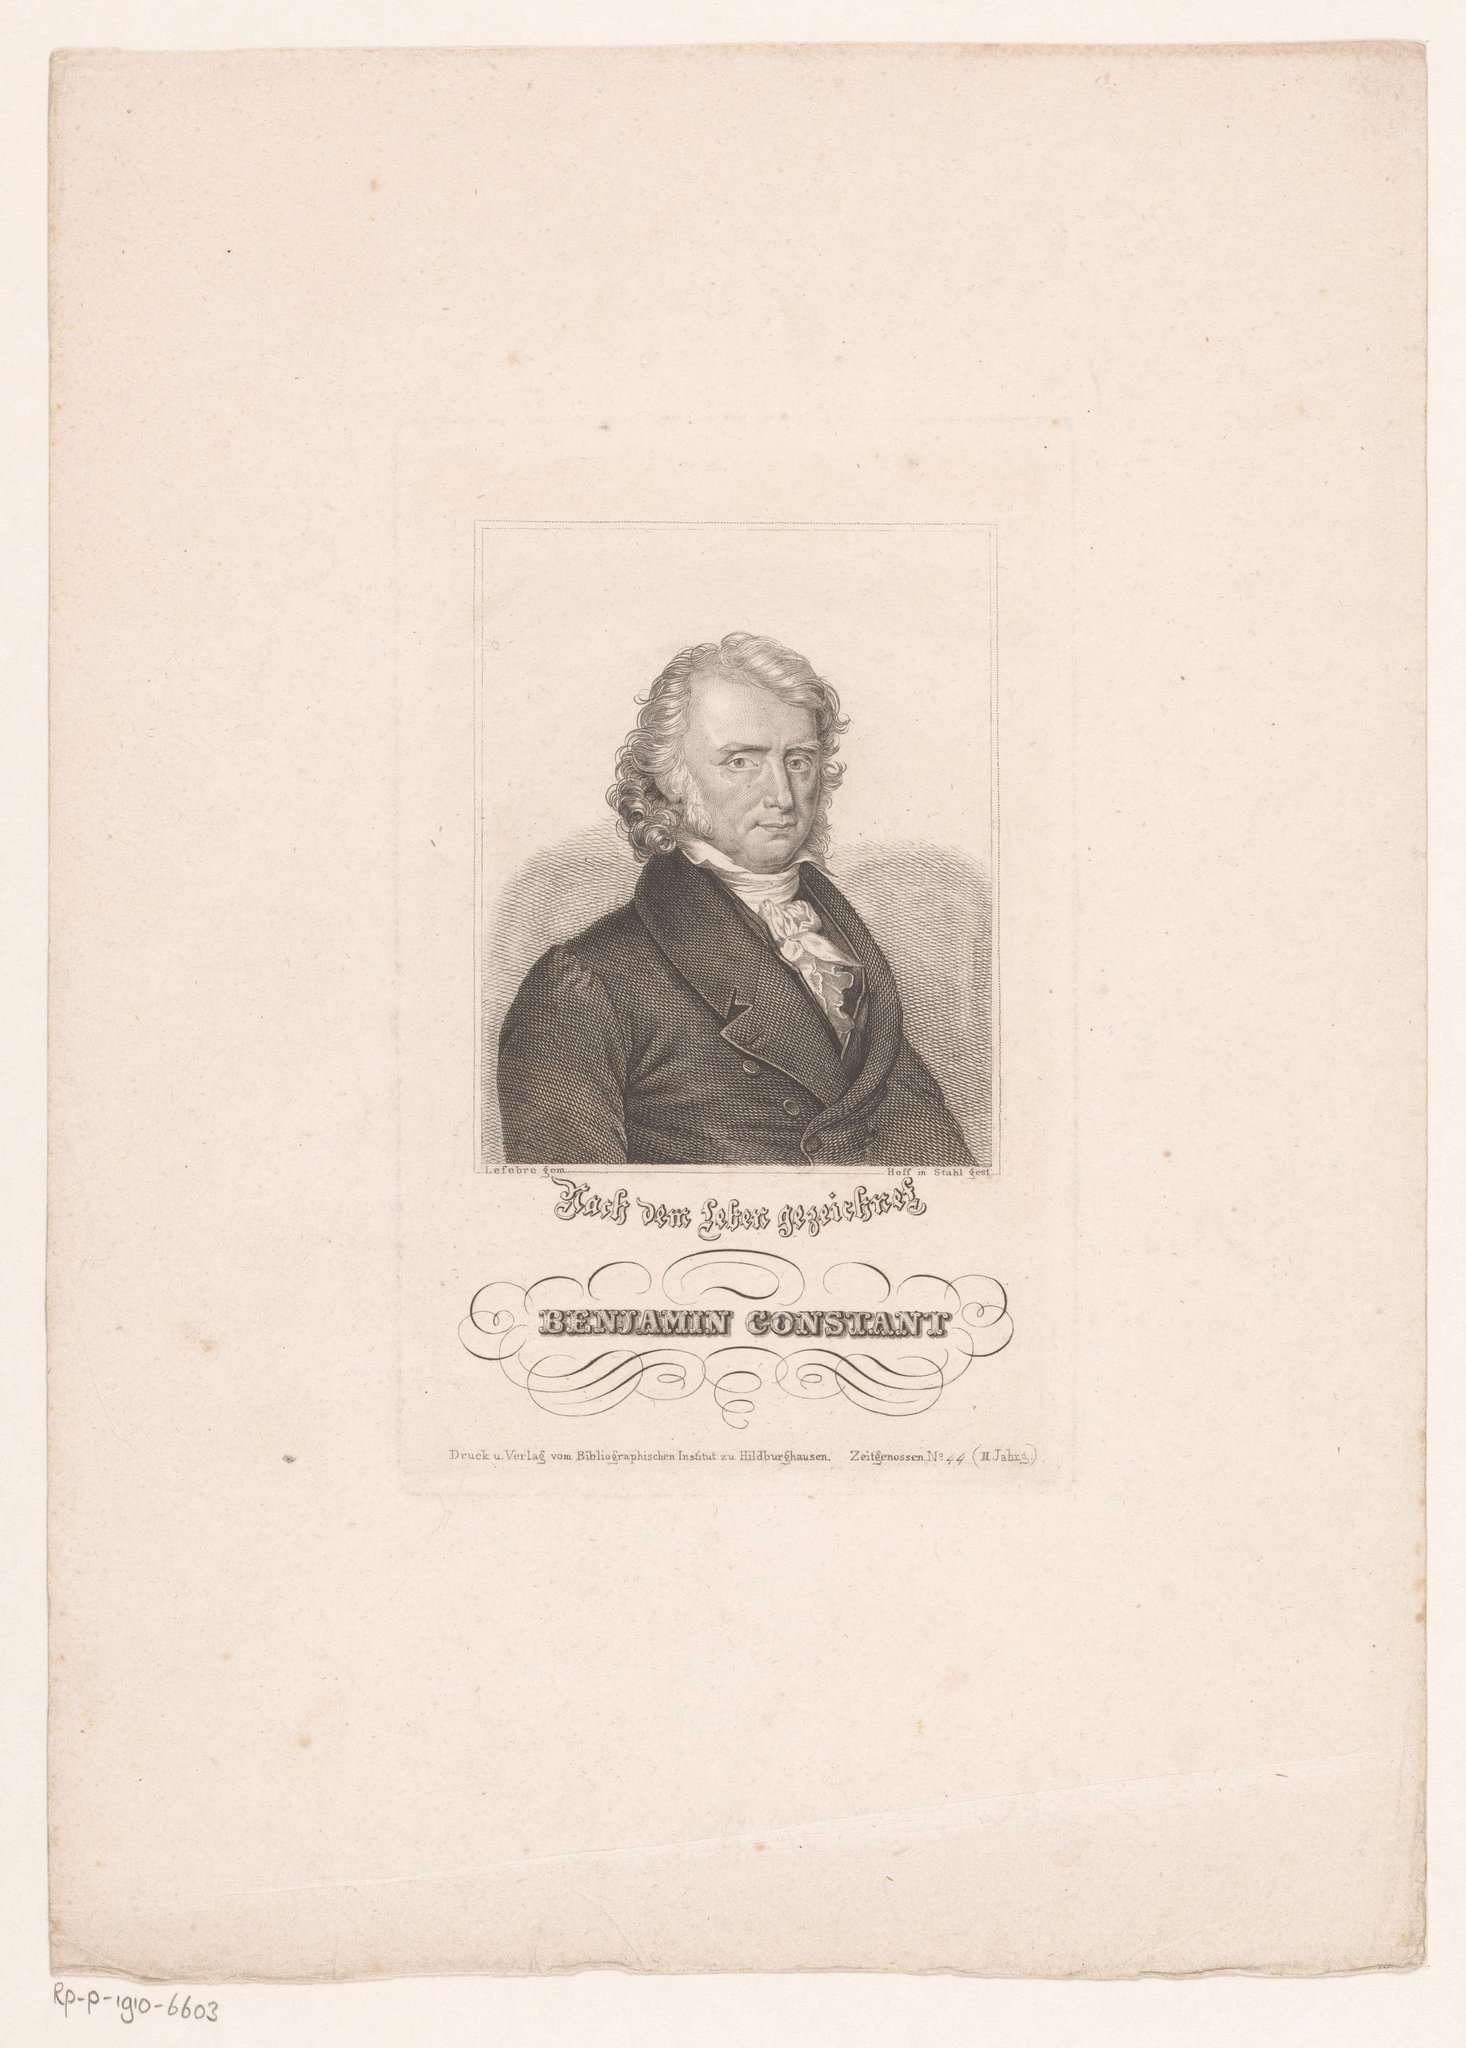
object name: print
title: Zeitgenossen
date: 1829-1840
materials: paper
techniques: engraving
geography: hildburghausen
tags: historical persons, politician, e.g. party leader, writer, poet, author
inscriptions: collector's mark: Lugt 2228